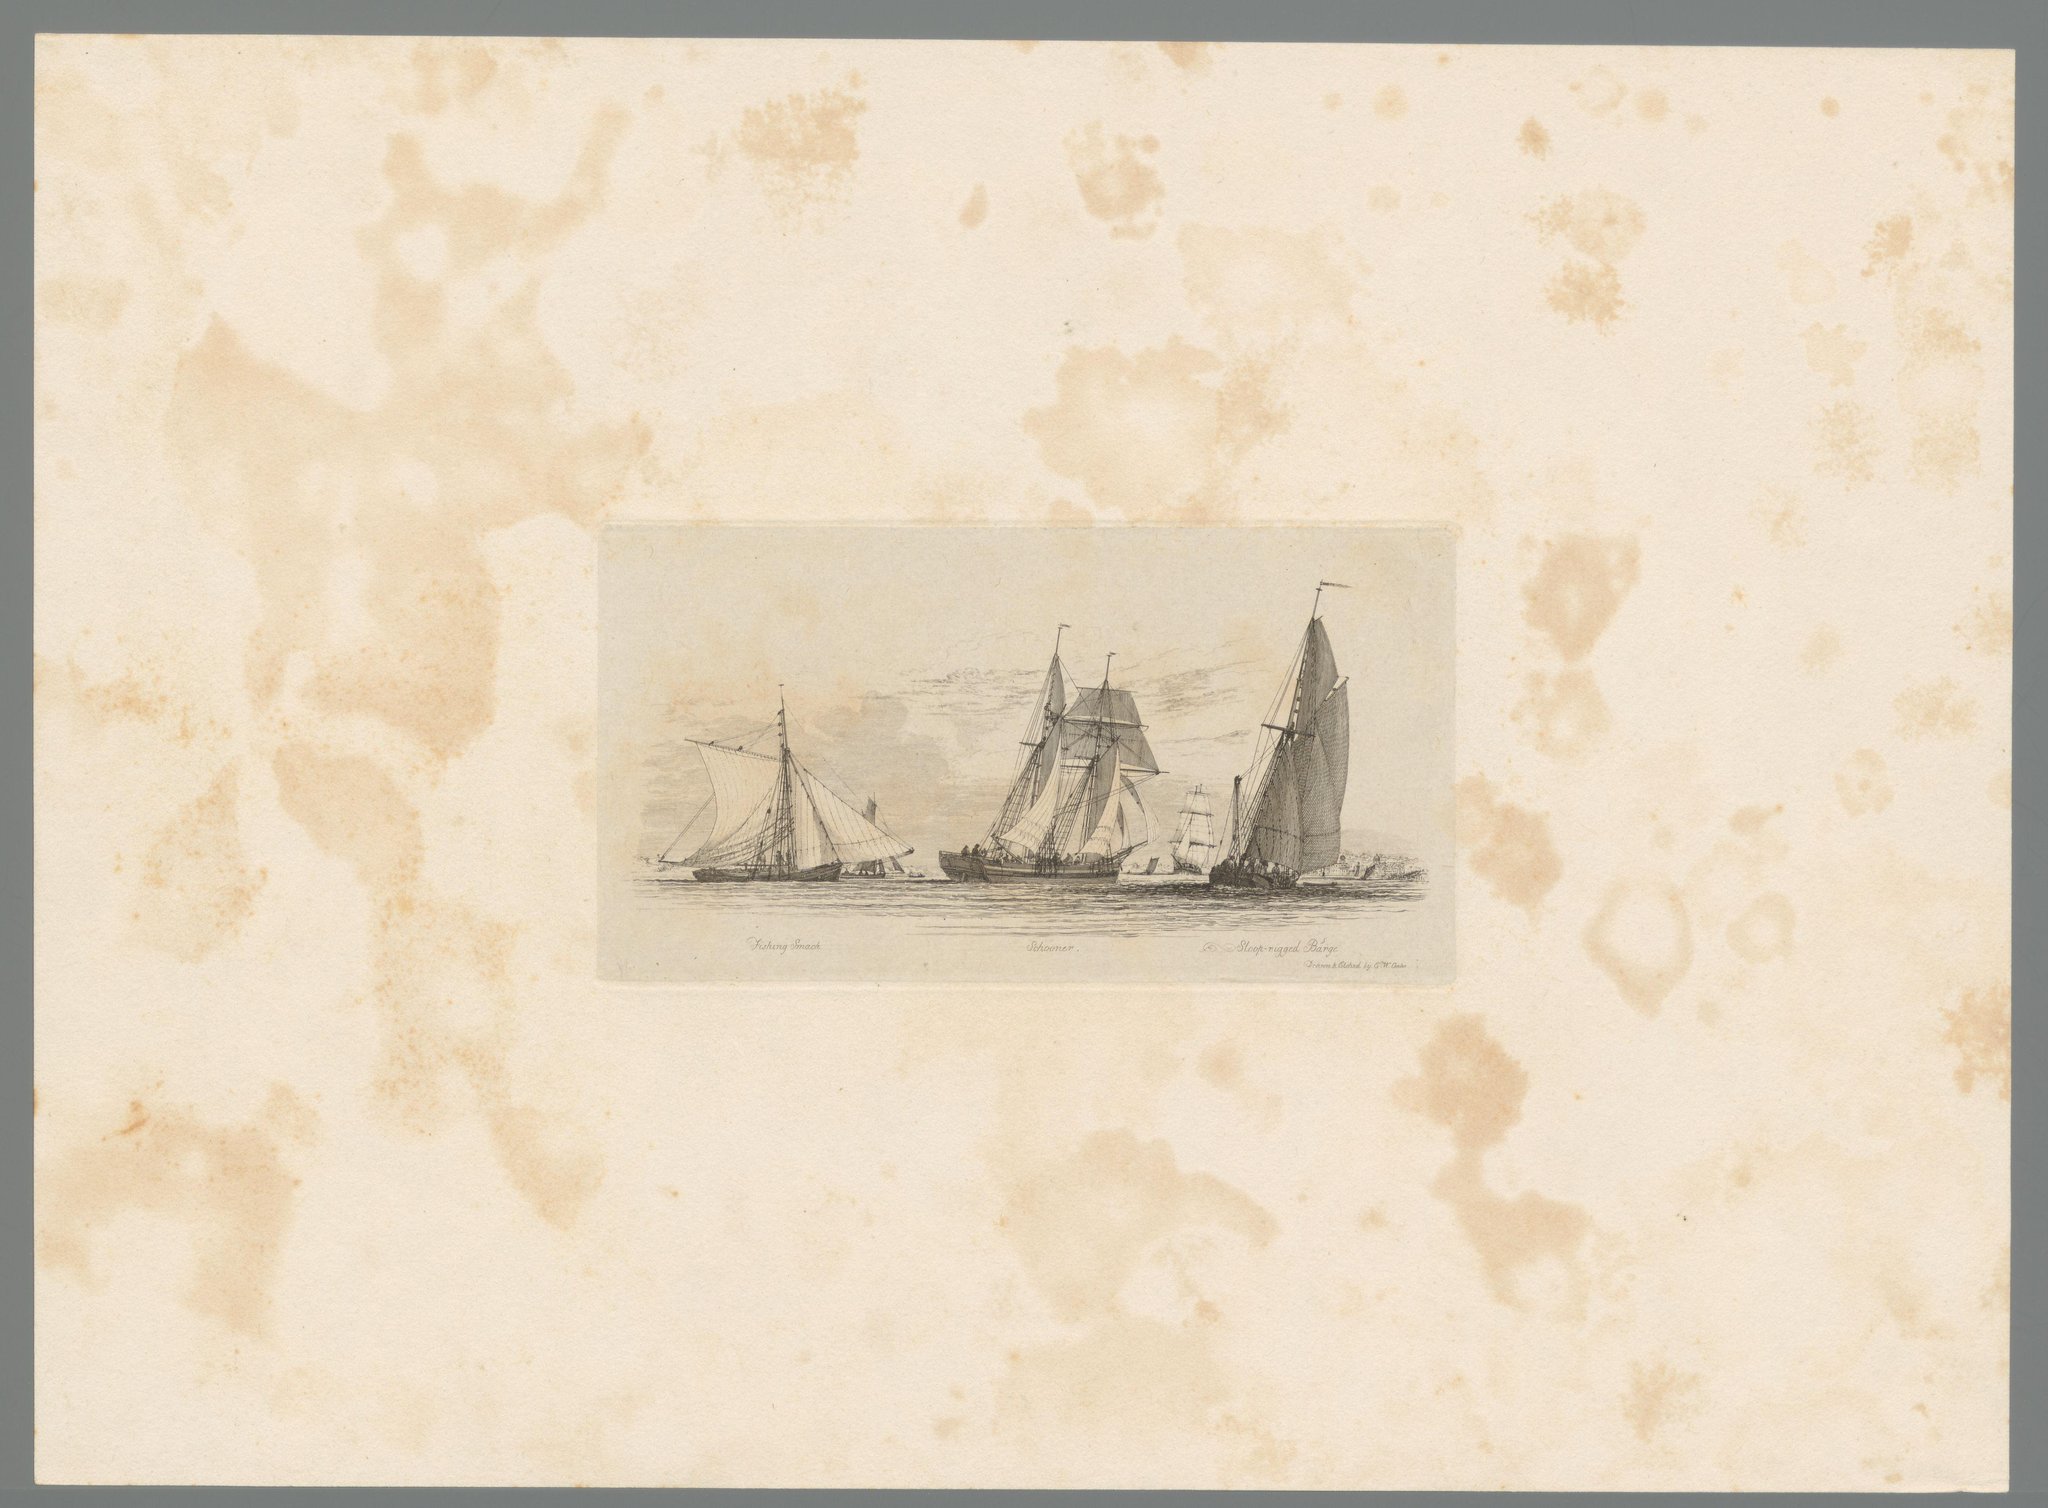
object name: print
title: Smak, schoener en zeilschip met één mast op het water bij Greenwich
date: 1828-1829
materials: paper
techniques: etching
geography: london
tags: city-view, and landscape with man-made constructions, sailing-ship, sailing-boat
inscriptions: collector's mark: Lugt 2165